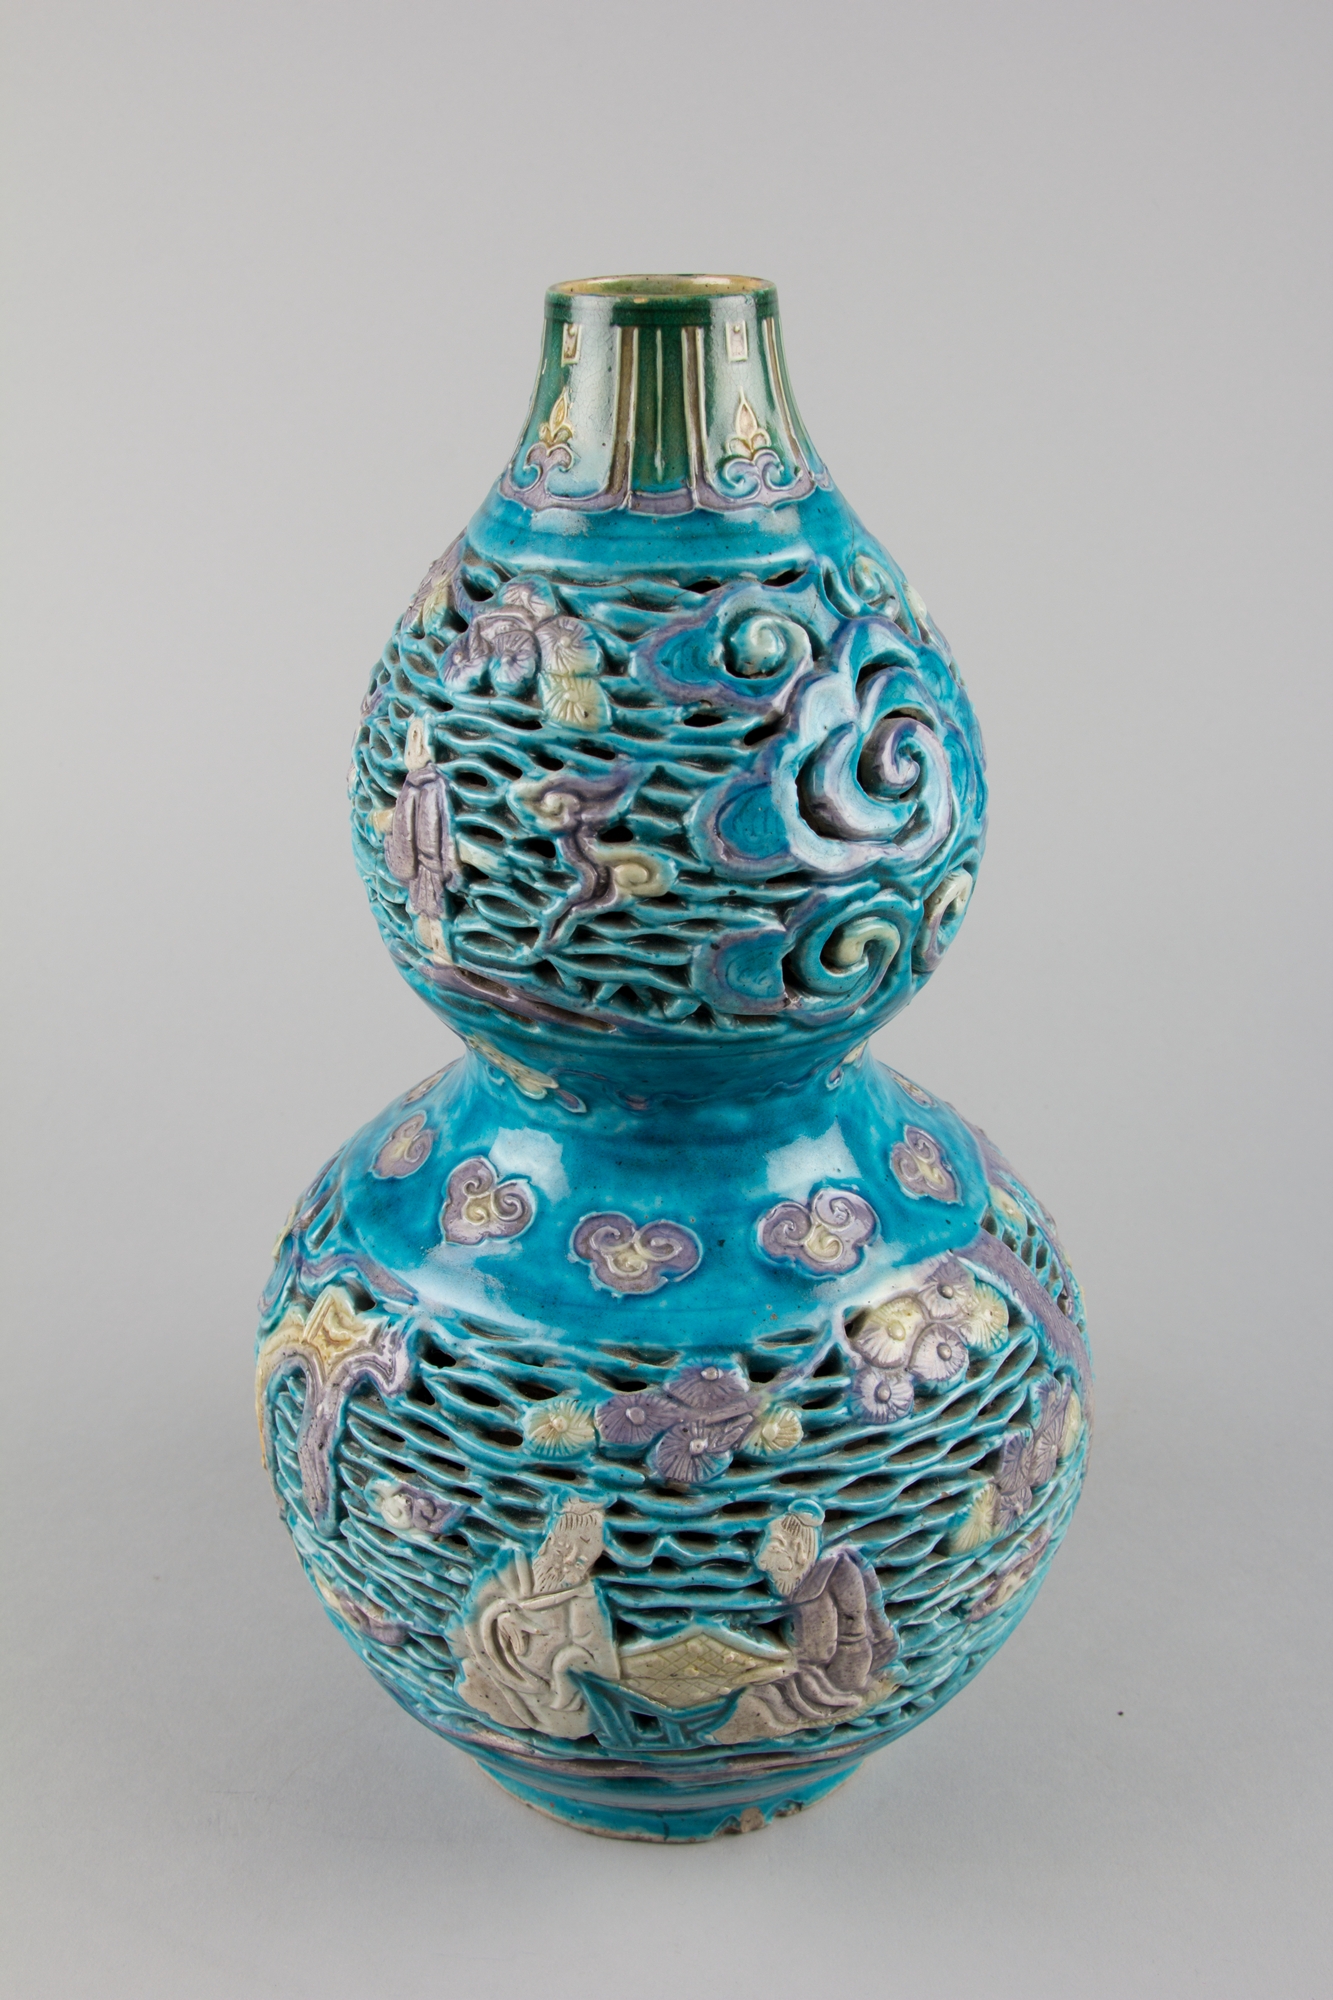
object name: vase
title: Double gourd bottle with immortals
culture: chinese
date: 1501-1600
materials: enamel, porcelain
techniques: polychrome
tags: human figures,flowers